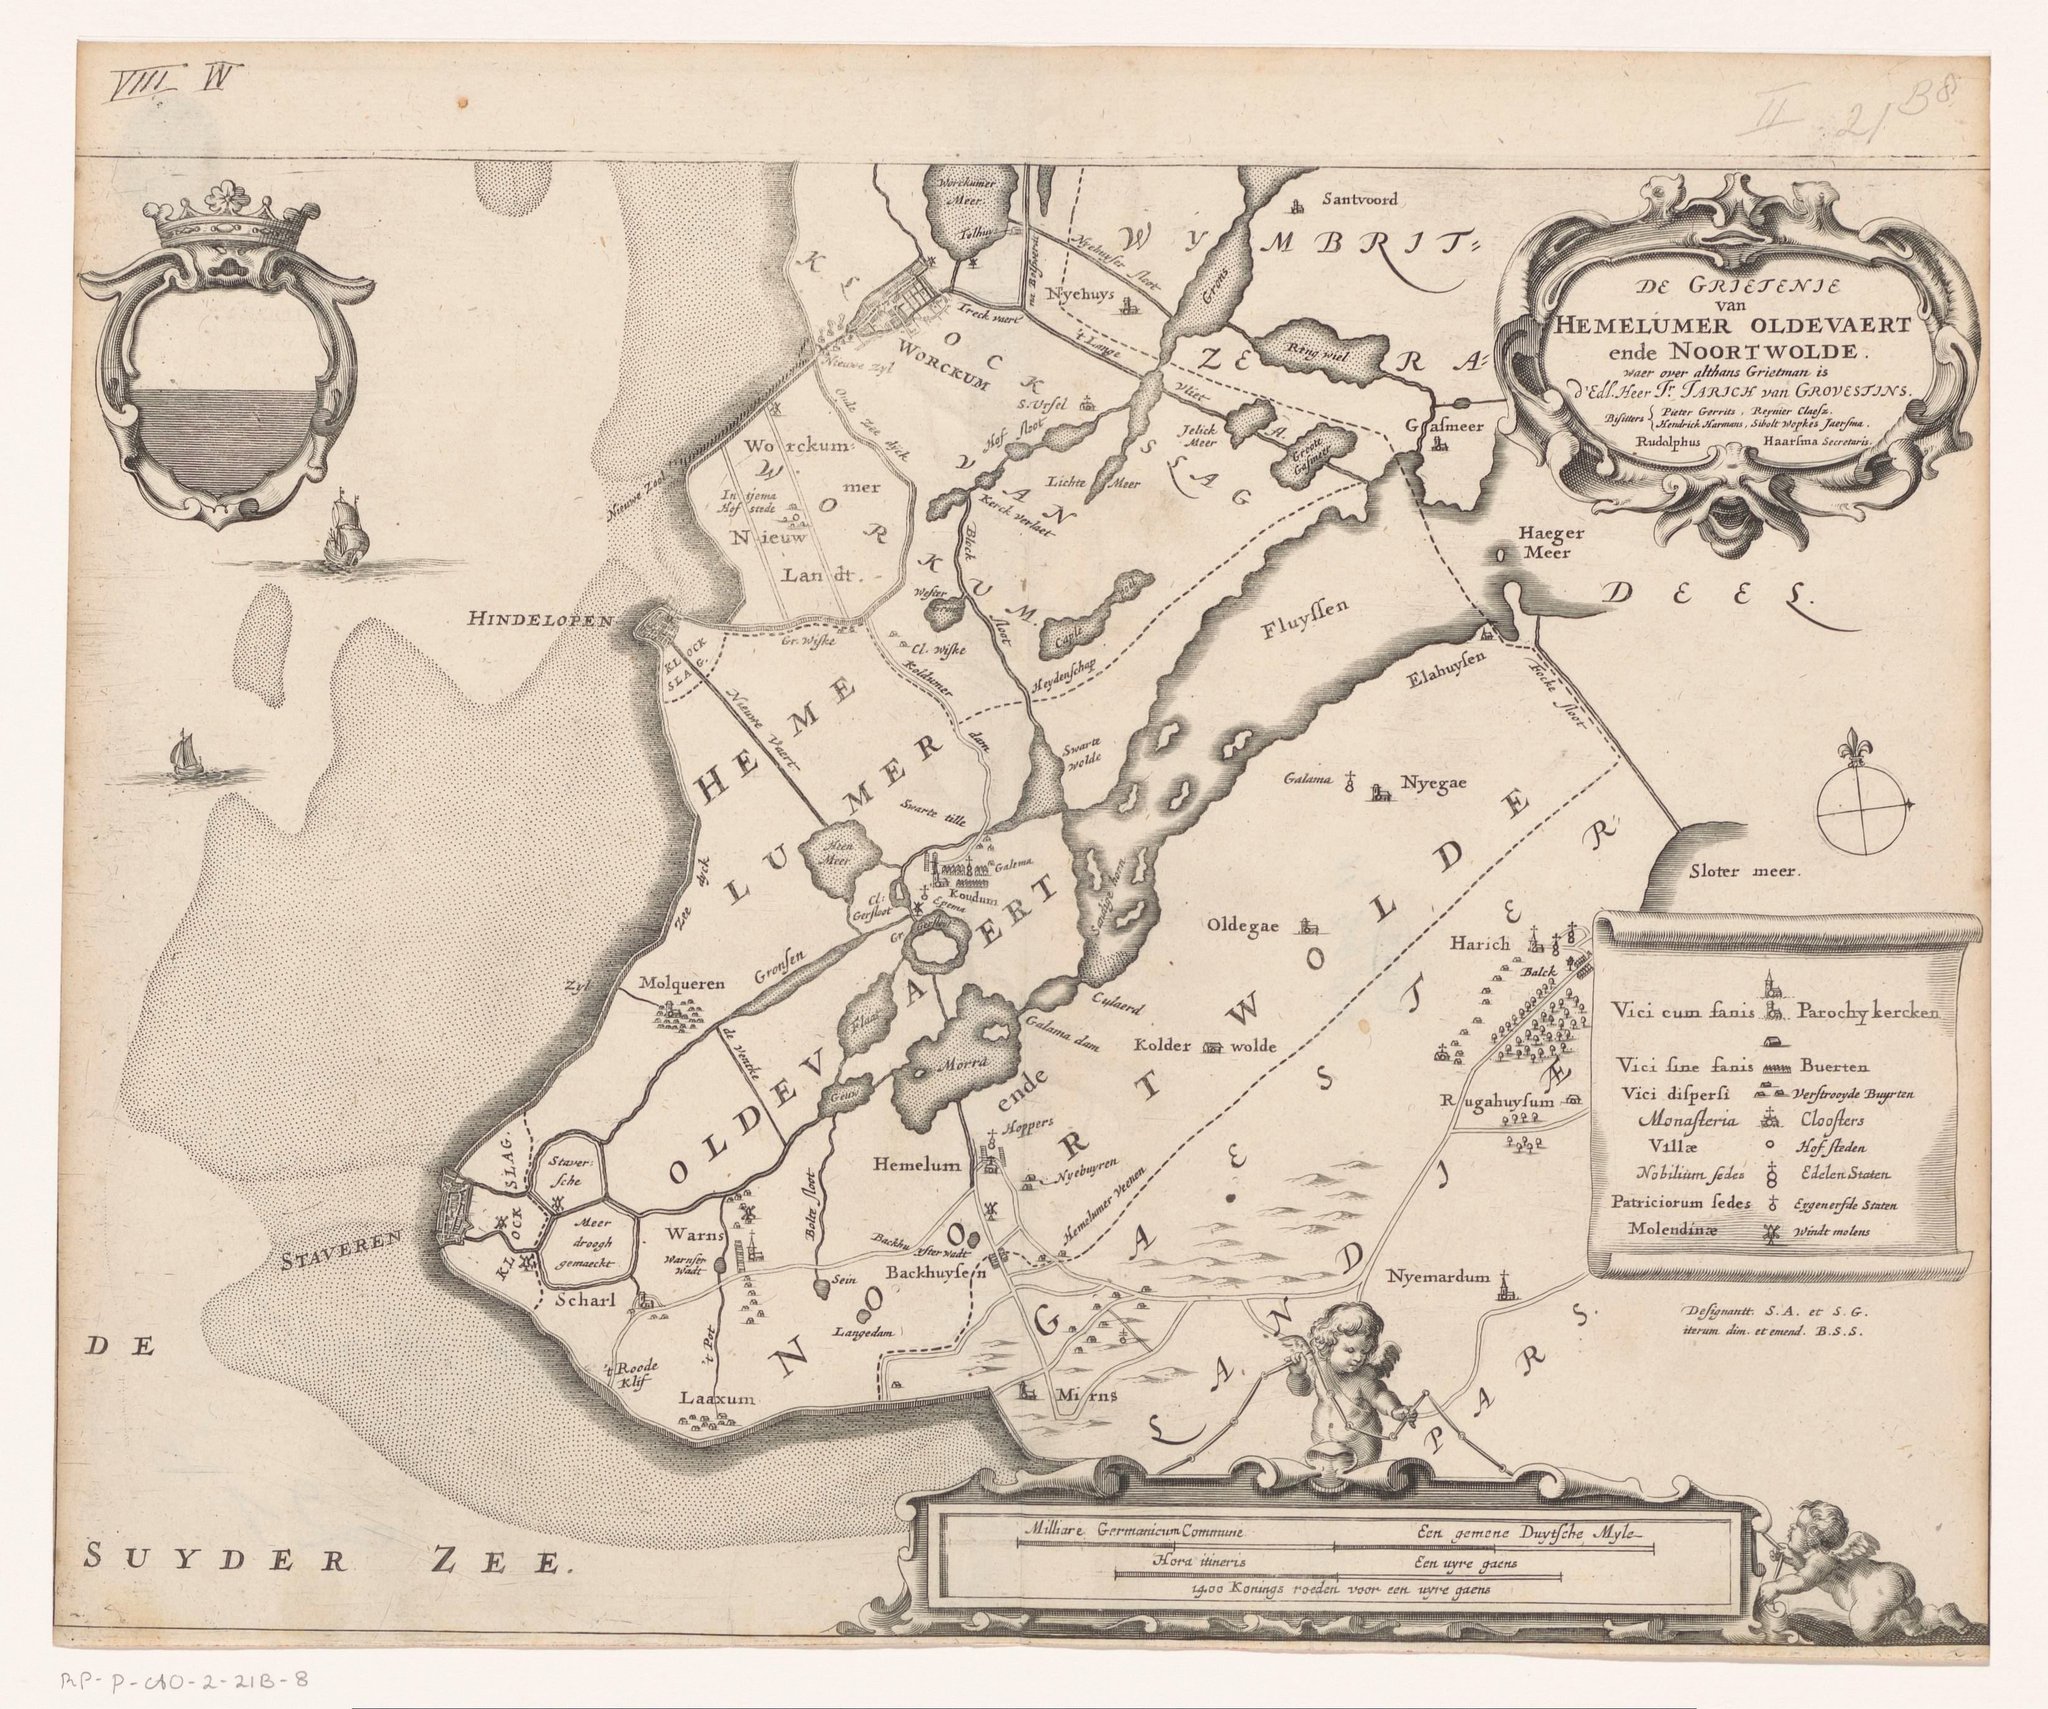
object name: print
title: Kaart van de grietenij Hemelumer Oldephaert en Noordwolde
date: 1664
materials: paper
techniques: engraving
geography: friesland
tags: coat of arms (as symbol of the state, etc.), maps of separate countries or regions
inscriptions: collector's mark: Lugt 2228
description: Linksboven het wapen van Hemelumer Oldephaert en Noordwolde. Rechtsoven cartouche met titel en bestuurlijke informatie over de grietenij, daaronder legenda. Helemaal onderaan twee schaalstokken: Milliare Germanicum commune / Een gemene Duytsche myle, Hora itineris / Een uyre gaens - van 1400 konings roeden voor een uyre gaens.